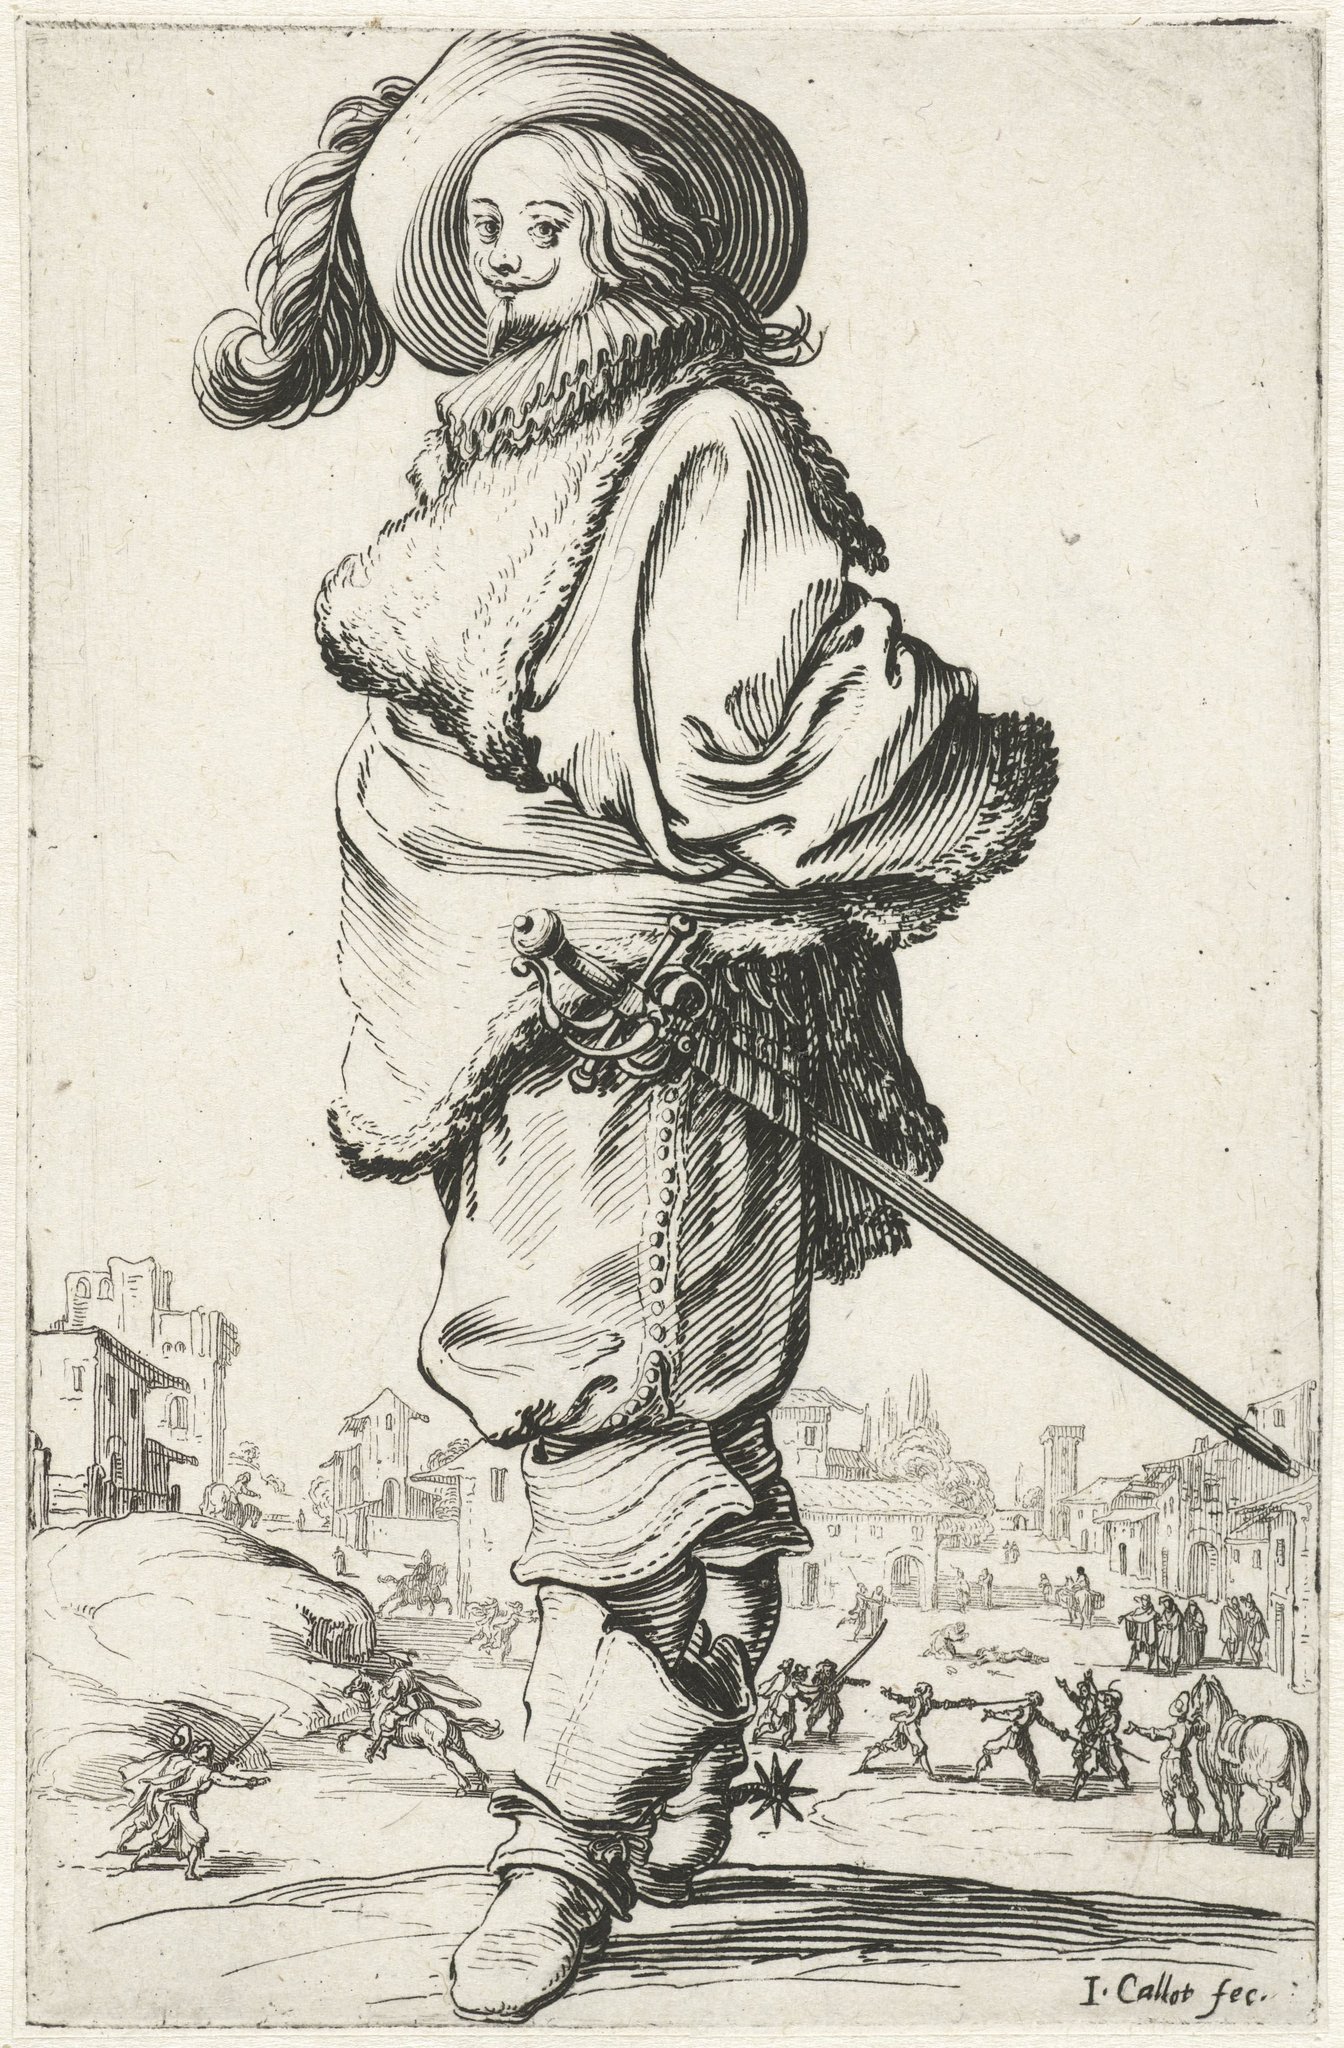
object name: costume print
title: La Noblesse de Lorraine (The Nobility of Lorraine)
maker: jacques callot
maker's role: draughtsman, print maker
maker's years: 1592-1635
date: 1620-1623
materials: paper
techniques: etching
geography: nancy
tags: neck-gear ~ clothing (with name) (+ men's clothes), cape (+ men's clothes), hacking and thrusting weapons: dagger, head-gear: hat (+ men's clothes), warfare; military affairs (+ cavalry, horsemen), clothes, costume (+ men's clothes), spur, trousers, breeches, etc. (breeches) (+ men's clothes), boots (+ men's clothes), head-gear: hat (+ feathers used for clothes), nobility and patriciate; chivalry, knighthood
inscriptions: collector's mark: Lugt 240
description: Courtly fashion in the French ducal city of Lorraine was all about the details. Men adorned their hats with feathers, their breeches with ribbons and their shoes with rosettes. Women grew increasingly fond of lace collars, the most lavish of which consisted of several layers and a garland of pearls. Intriguingly, it is not clear whether Callot intended to portray the true nobility or the bourgeois citizens who emulated them.